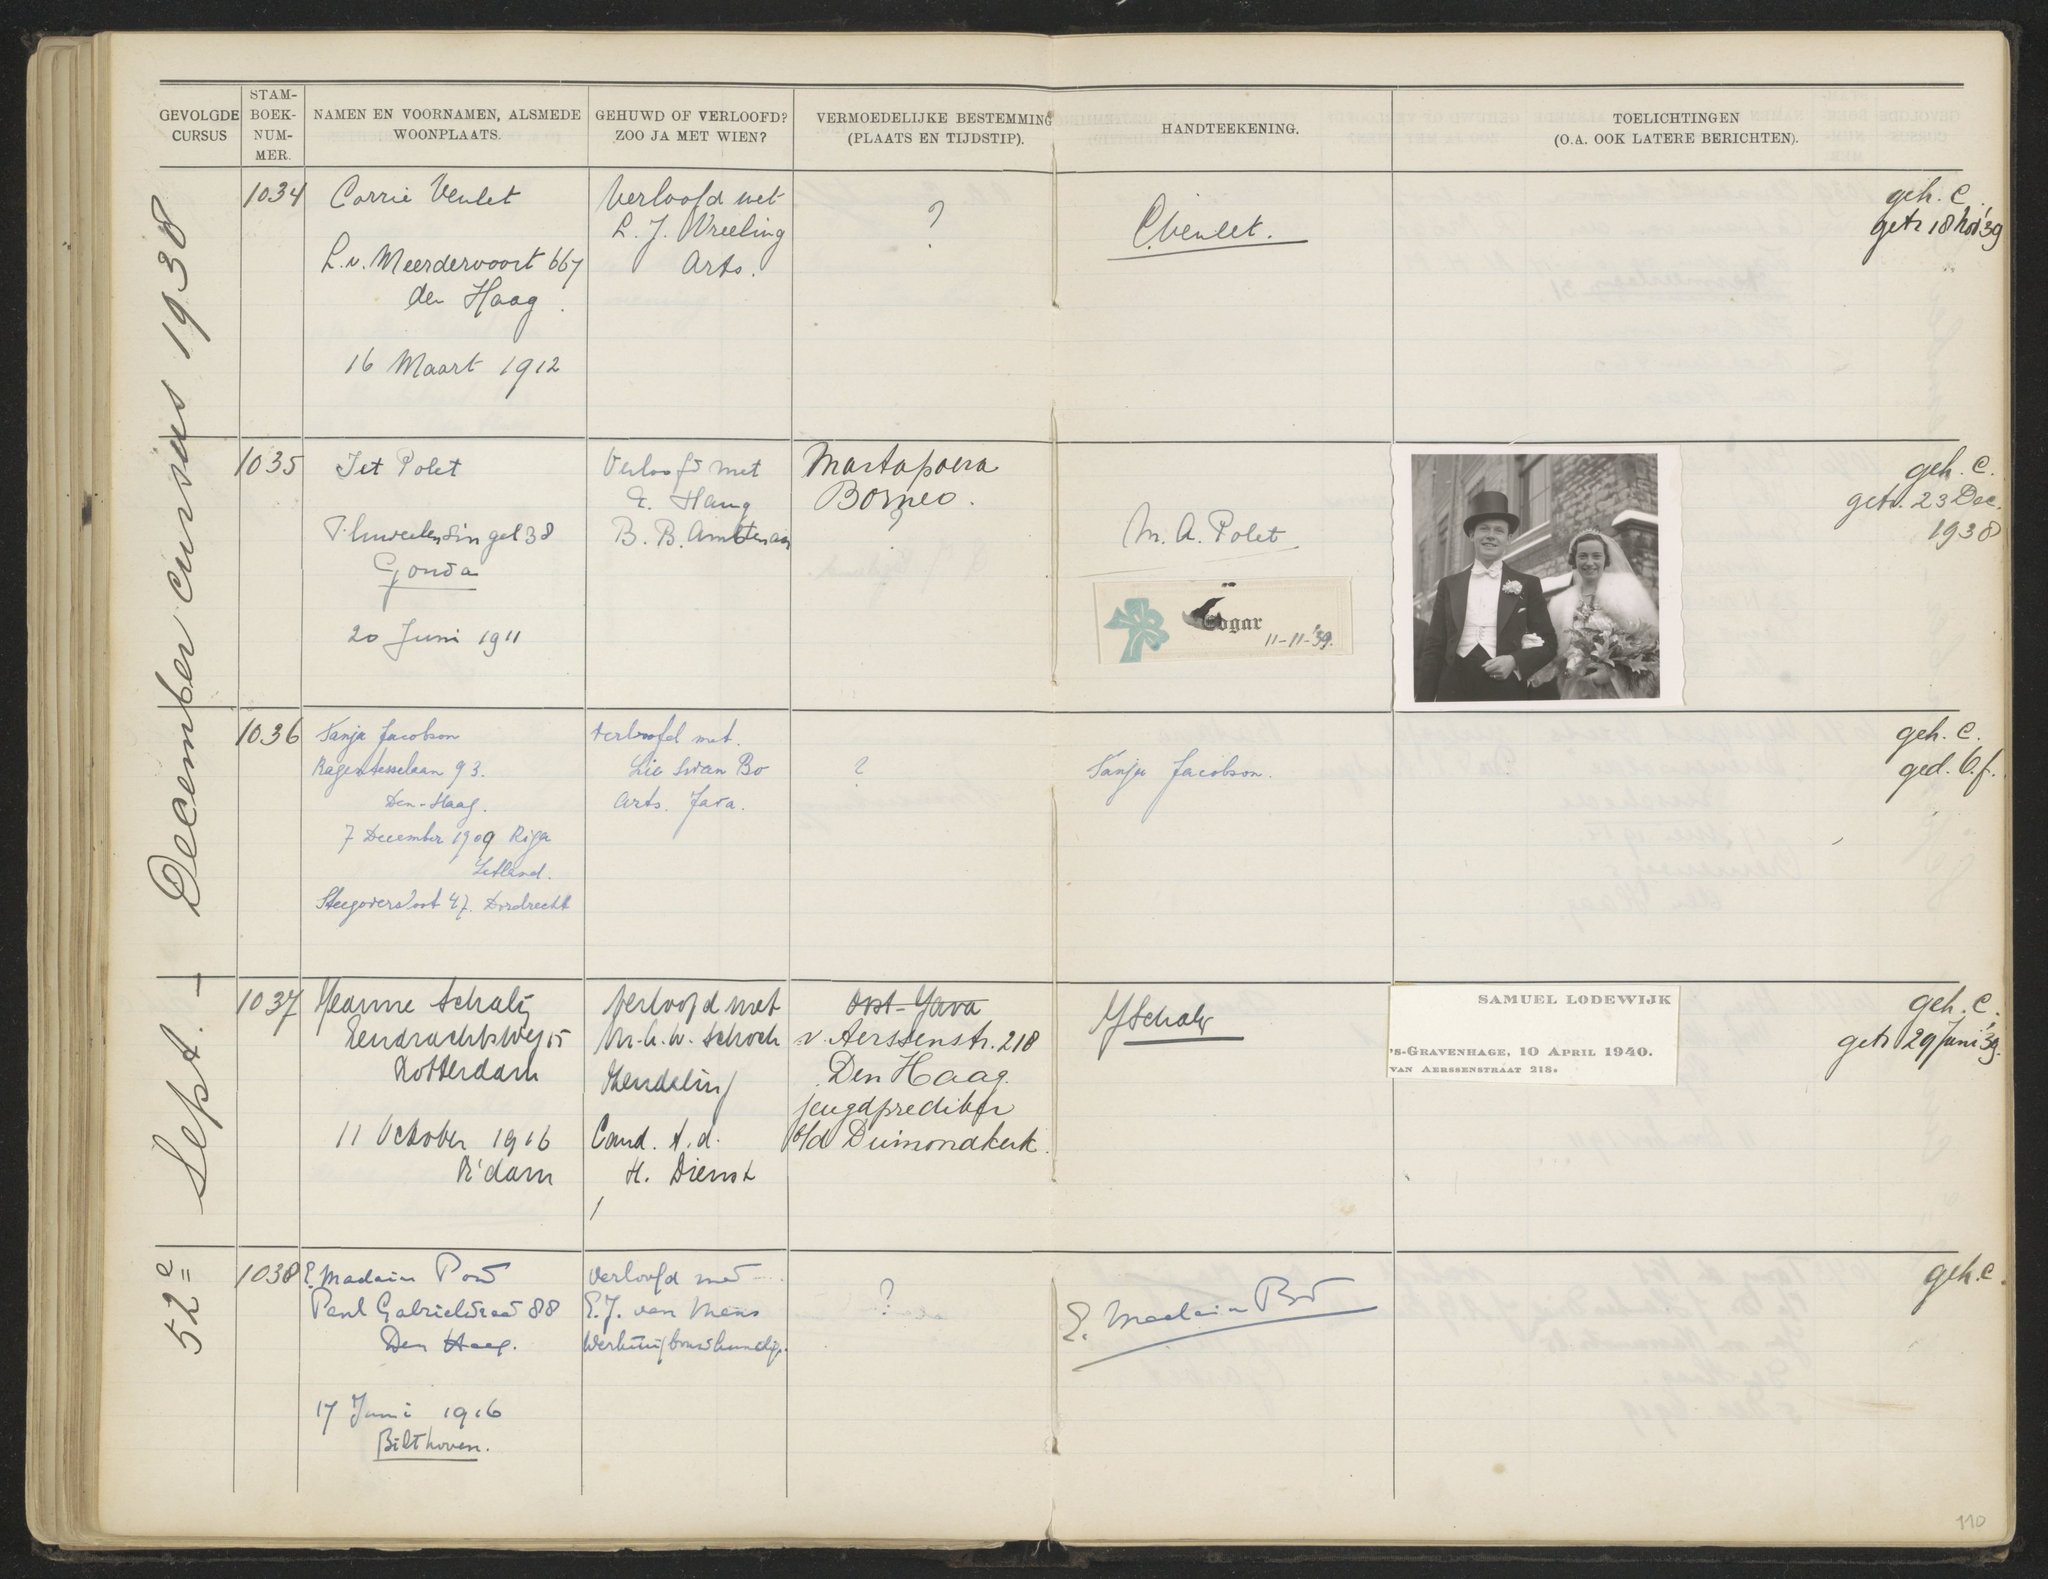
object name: album leaf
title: Blad 110 uit Stamboek van de leerlingen der Koloniale School voor Meisjes en Vrouwen te 's-Gravenhage deel II (1930-1949)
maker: Anonymous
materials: paper, photographic support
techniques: photography, printing, writing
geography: the hague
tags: further education (+ pupil), further education, the hague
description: Twee pagina's met gegevens van de deelnemers aan de 52e driemaandelijkse cursus van september tot december 1938, stamboeknummers 1034 tot en met 1038. Onderdeel van Stamboek van de leerlingen der Koloniale School voor Meisjes en Vrouwen te 's-Gravenhage deel II (1930-1949).